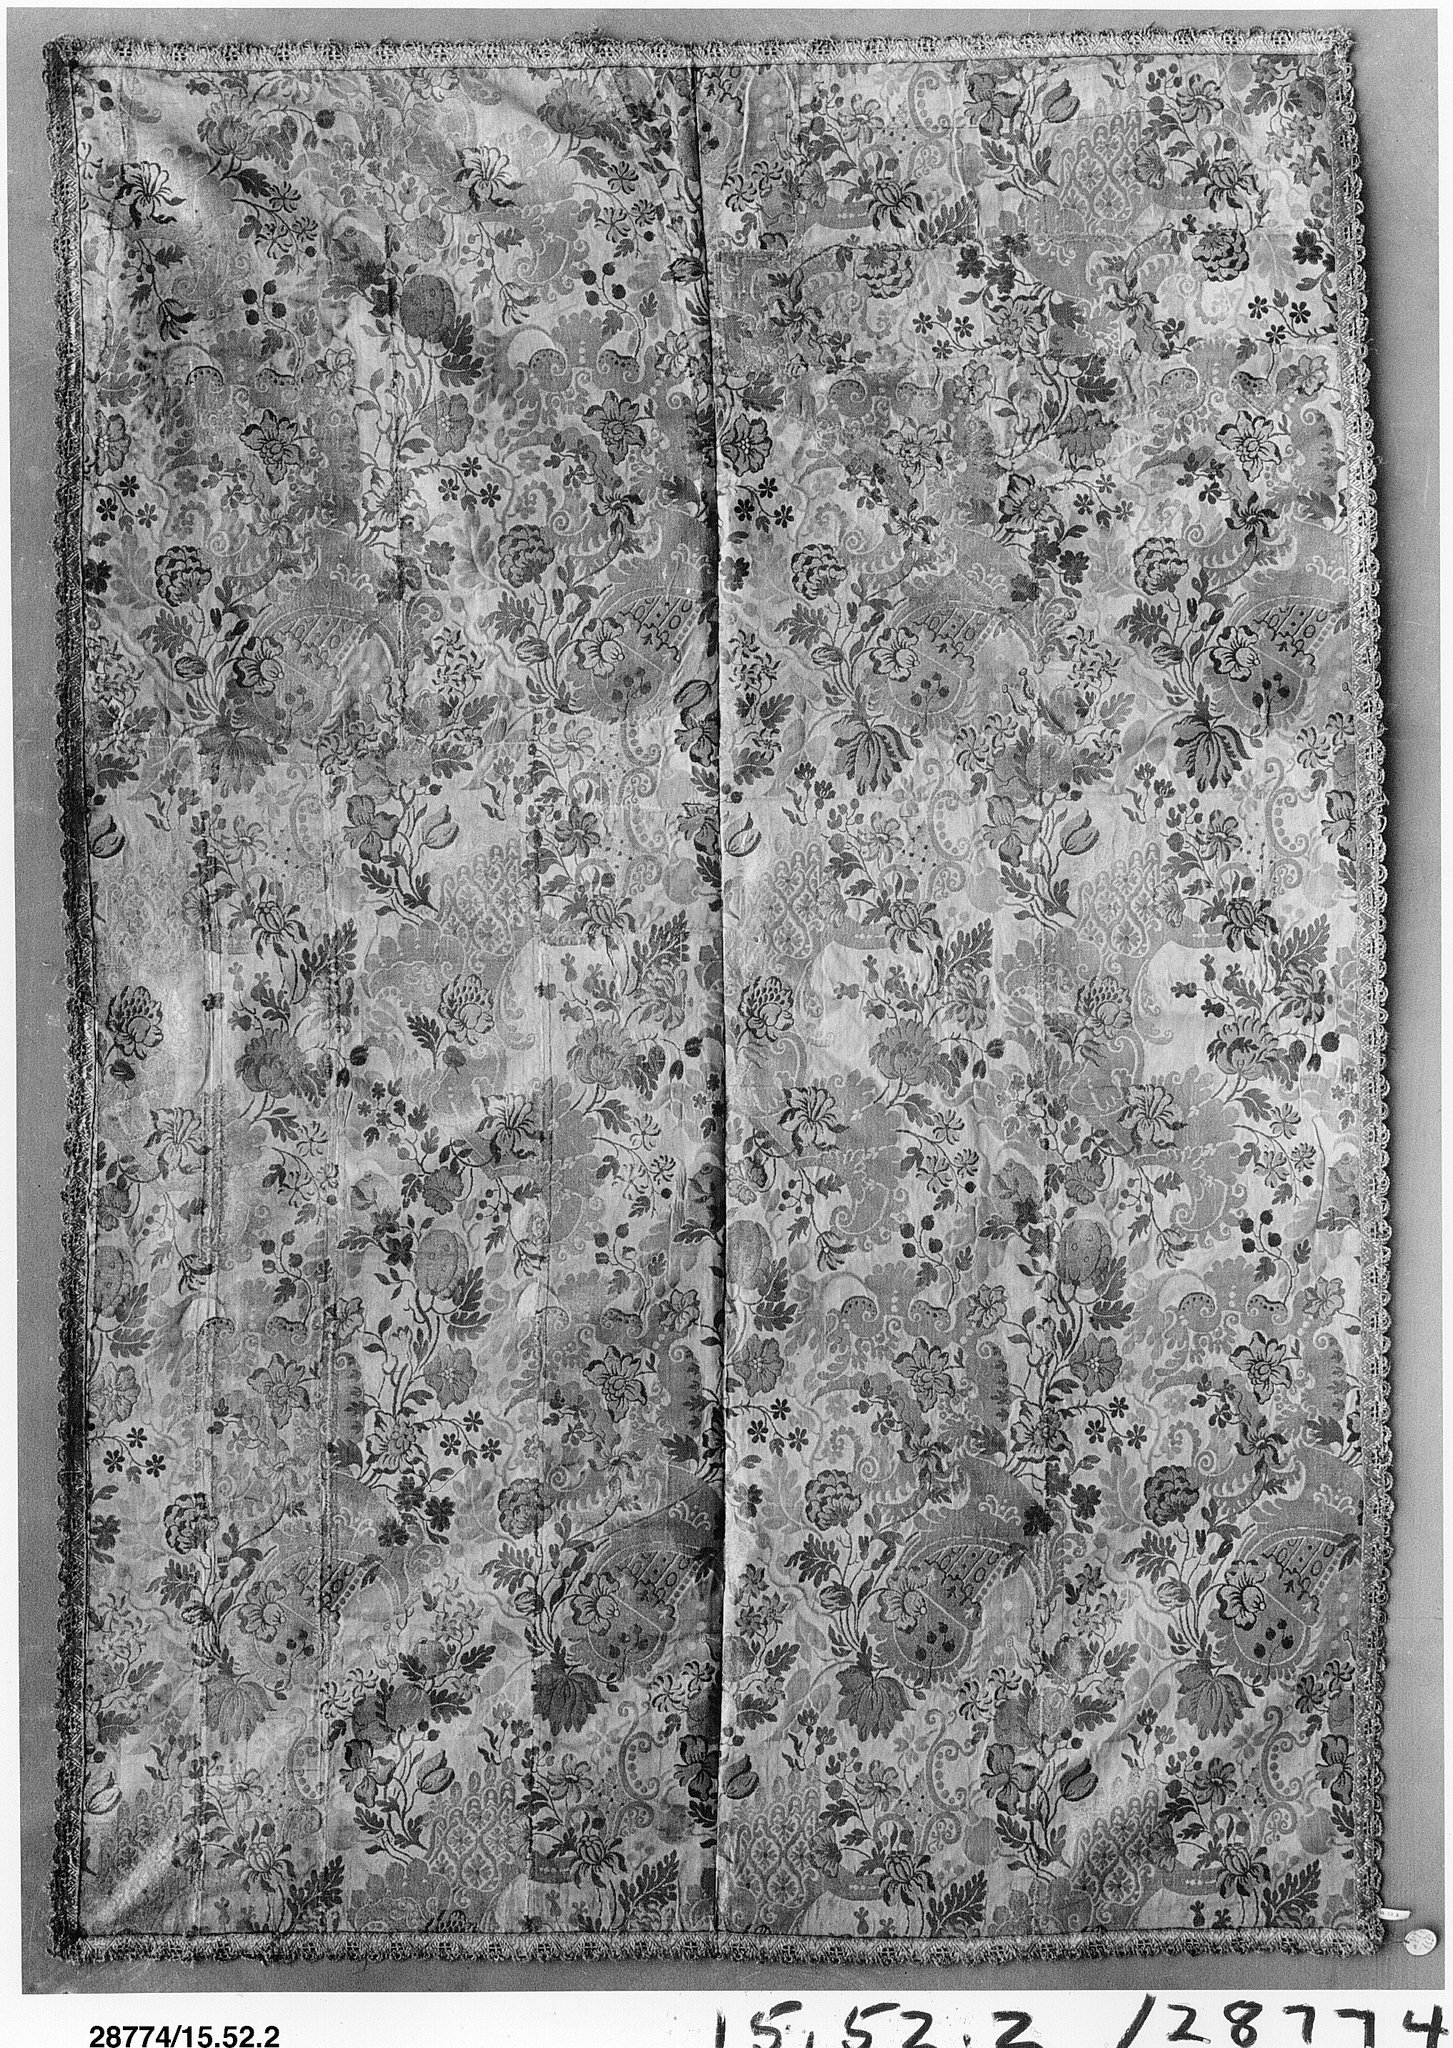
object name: panel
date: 1720-1730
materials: metal thread, silk